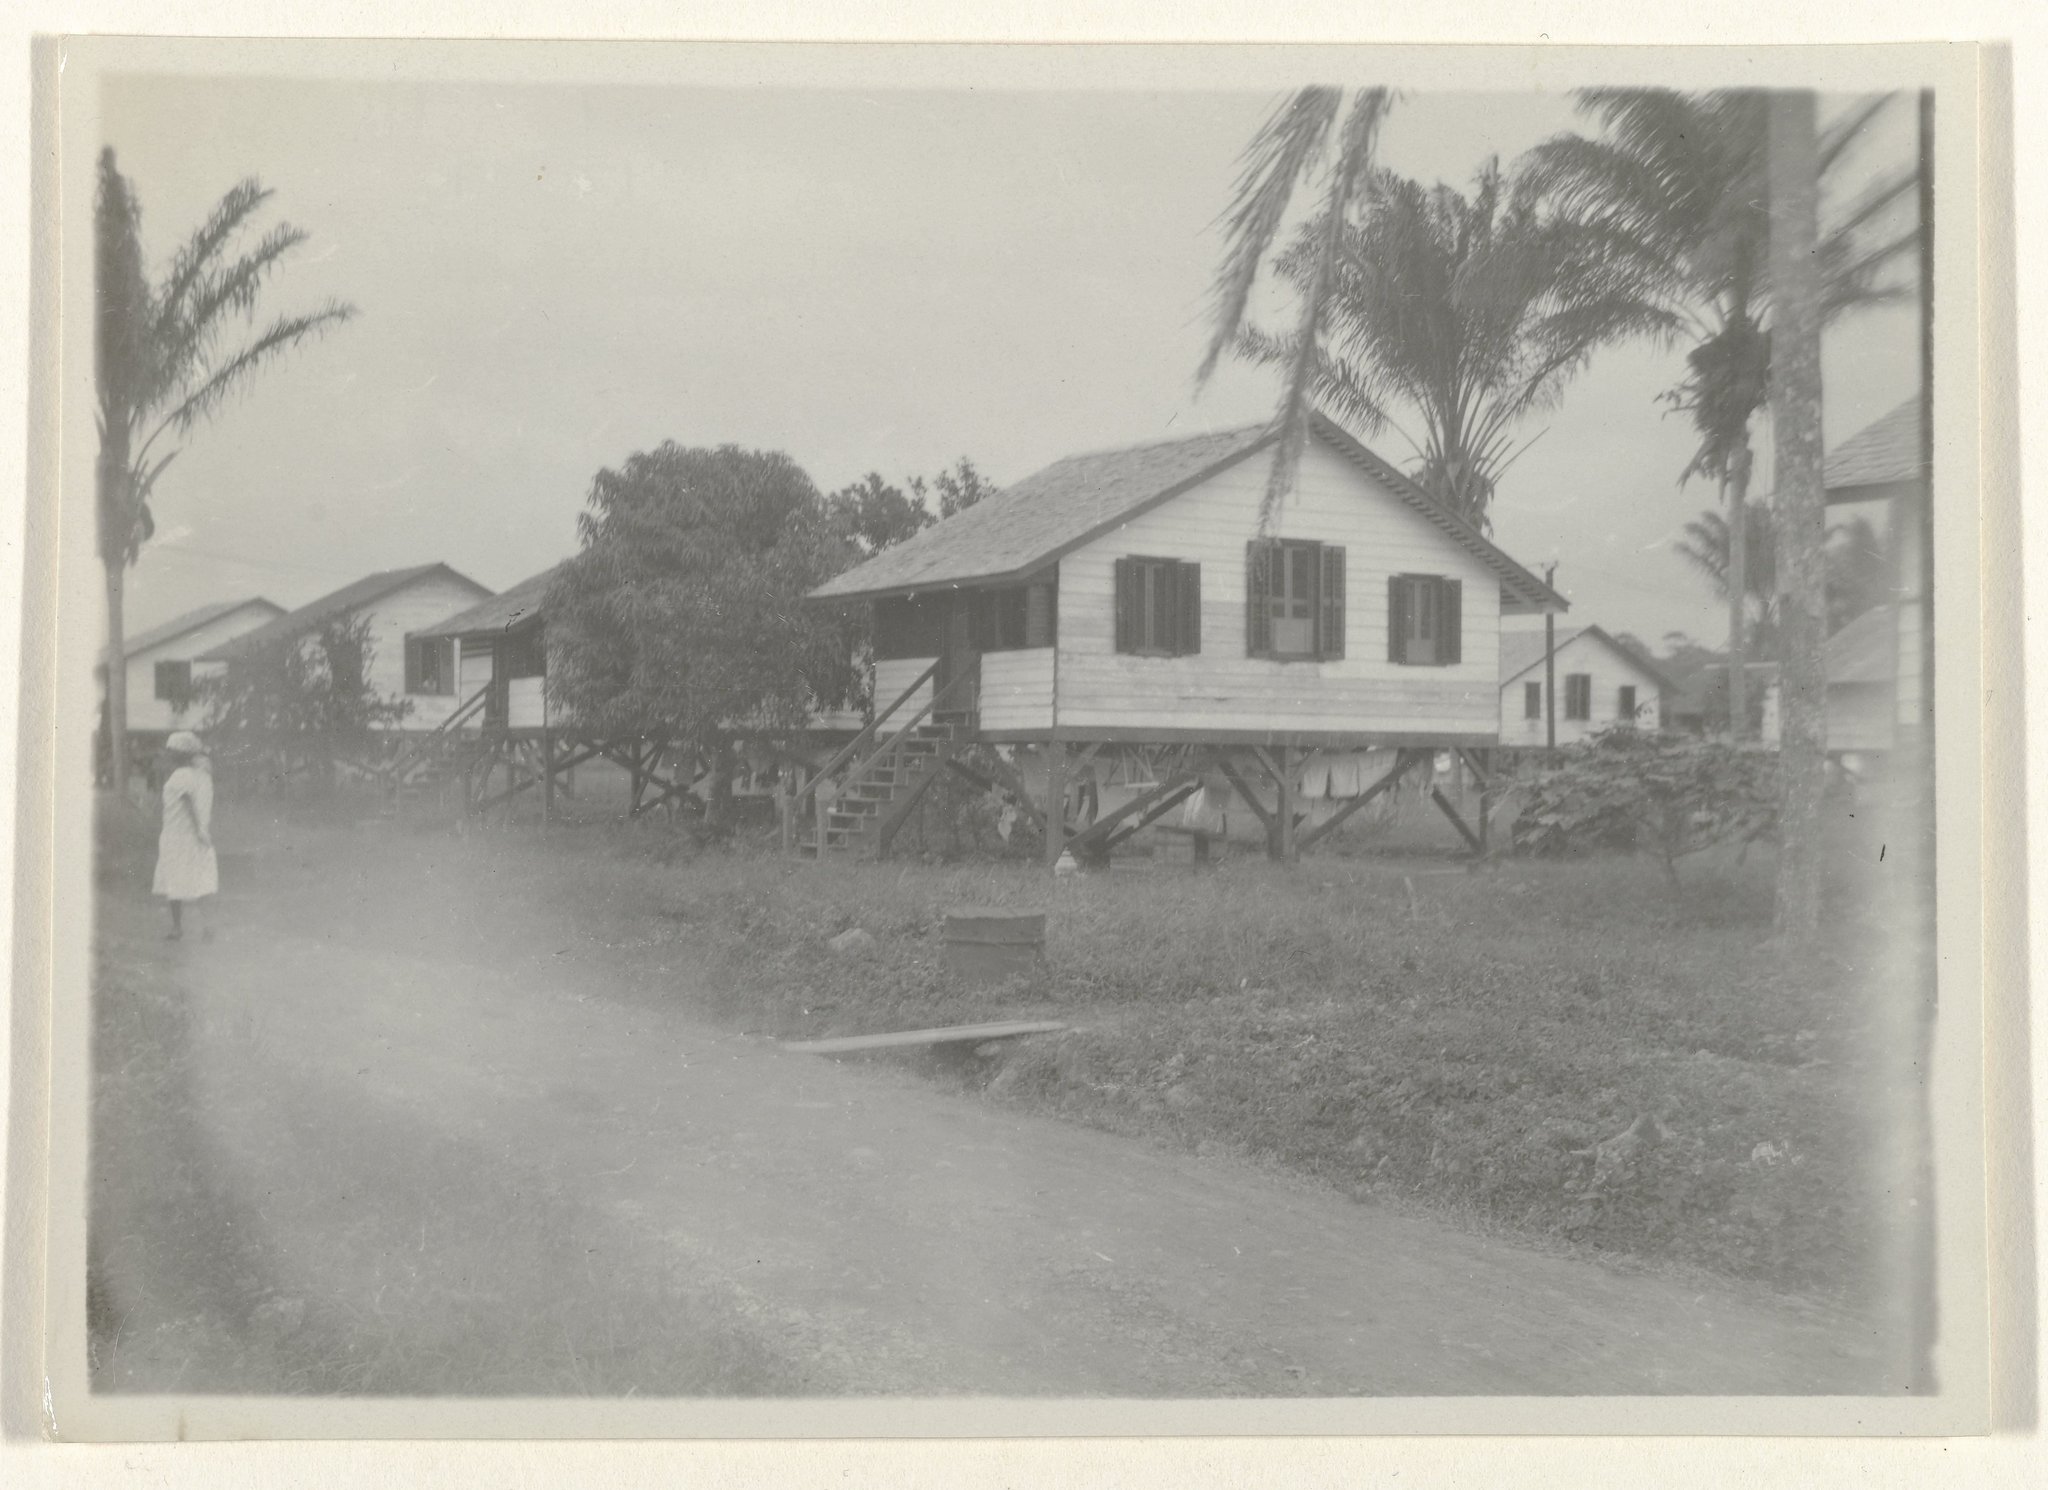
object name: photograph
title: Woningen in Moengo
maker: Anonymous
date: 1929-1930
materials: photographic support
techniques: photography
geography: suriname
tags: village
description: Ambtswoningen voor hogere medewerkers van de Surinaamse bauxietmaatschappij.